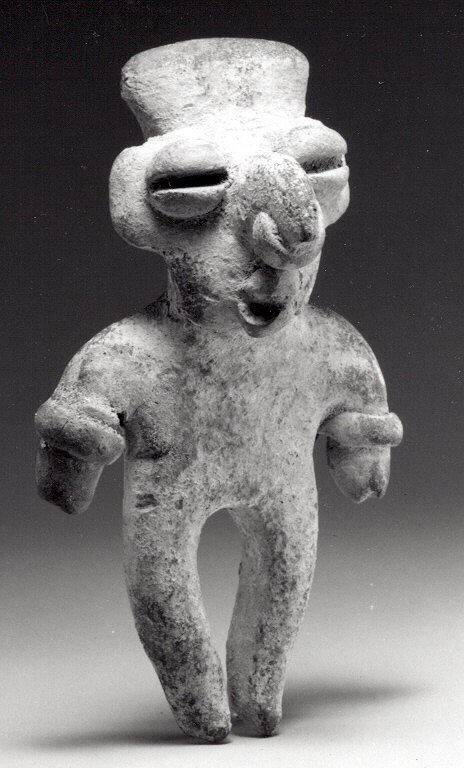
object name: figure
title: Standing Figure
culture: bahía or esteros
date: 500-1 BCE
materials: ceramic, pigment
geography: ecuador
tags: human figures